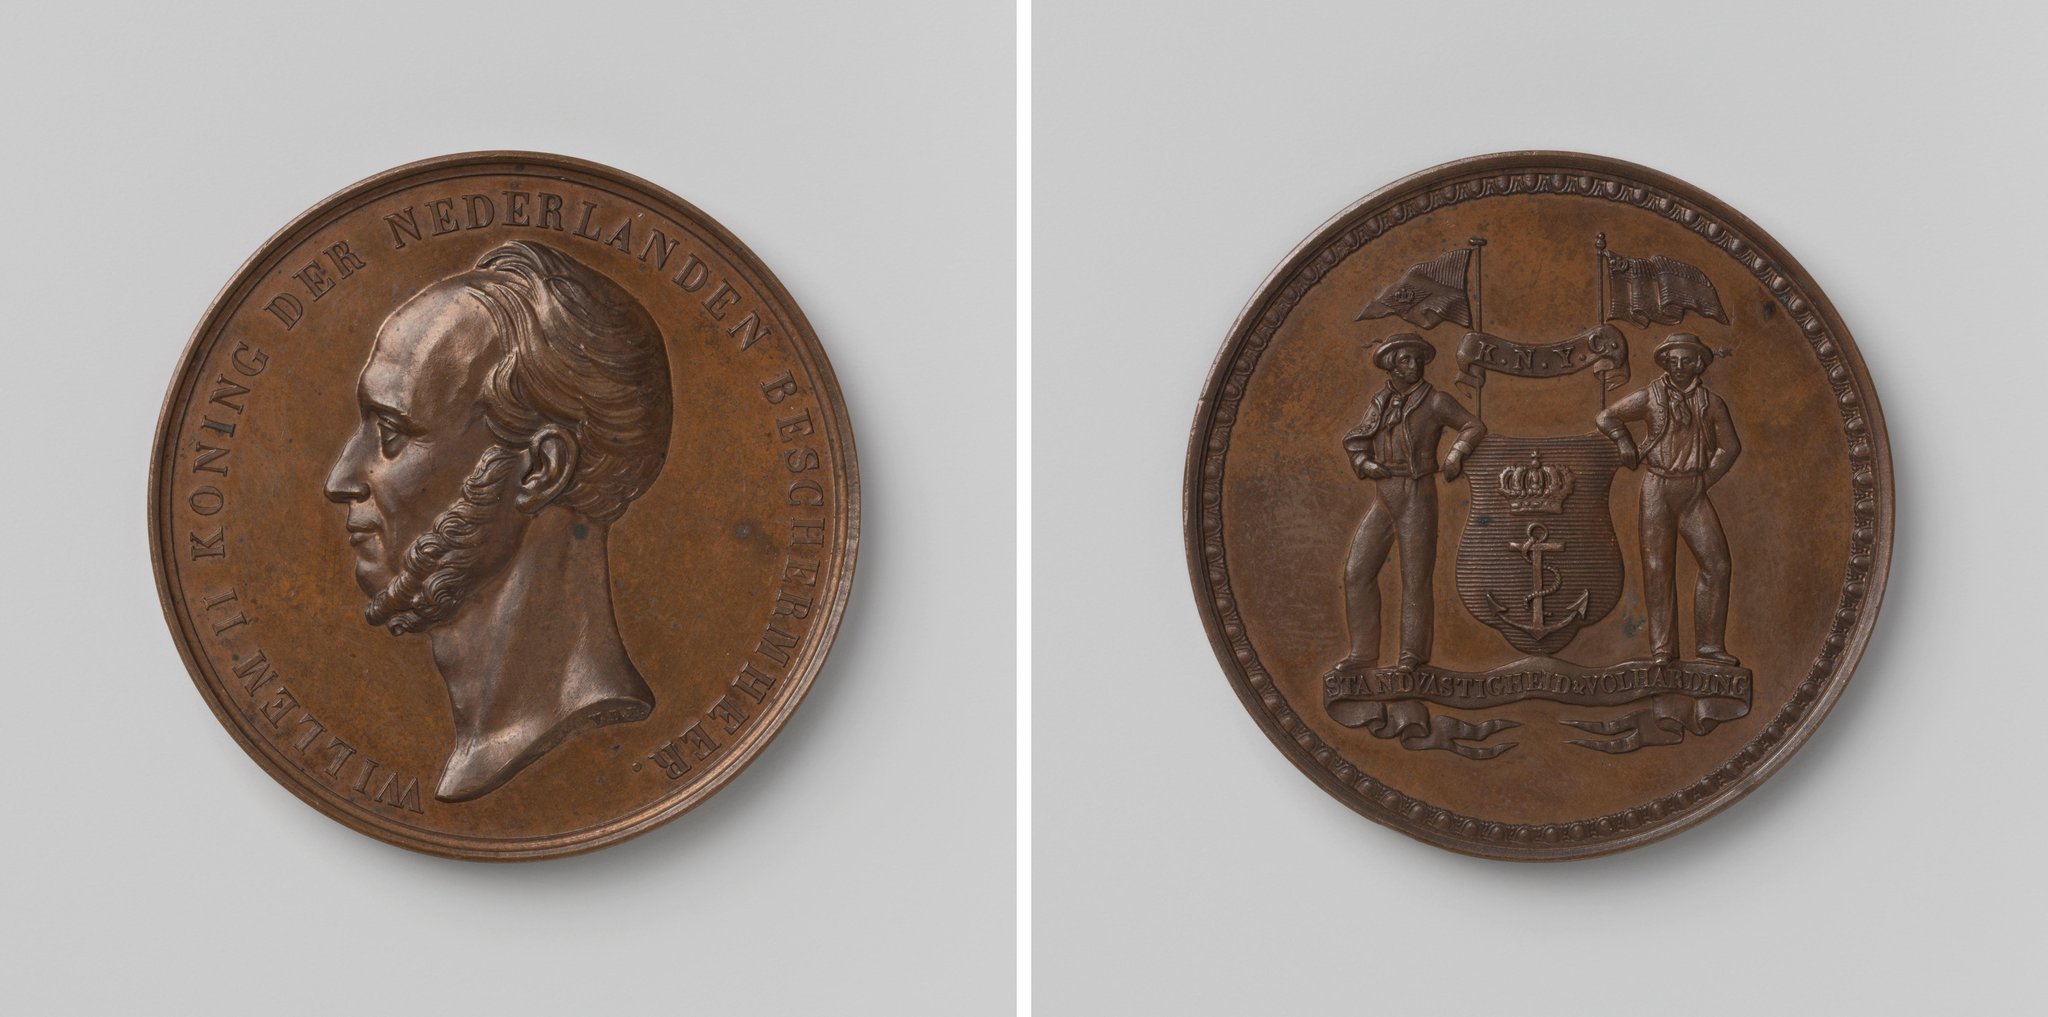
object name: honorary medal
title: Willem II, koning der Nederlanden, beschermheer der Koninklijke Nederlandsche Yachtclub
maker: david van der kellen (1804-1879)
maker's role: die cutter, draughtsman, print maker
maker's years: 1804-1879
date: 1841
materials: bronze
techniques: striking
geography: utrecht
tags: the hague, william ii of the netherlands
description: Bronzen penning. Voorzijde: borststuk man binnen omschrift. Keerzijde: wapenschild, bekroond met twee vlaggen, die door lint met opschrift verbonden worden, geflankeerd door twee matrozen boven wimpel met opschrift binnen sierrand